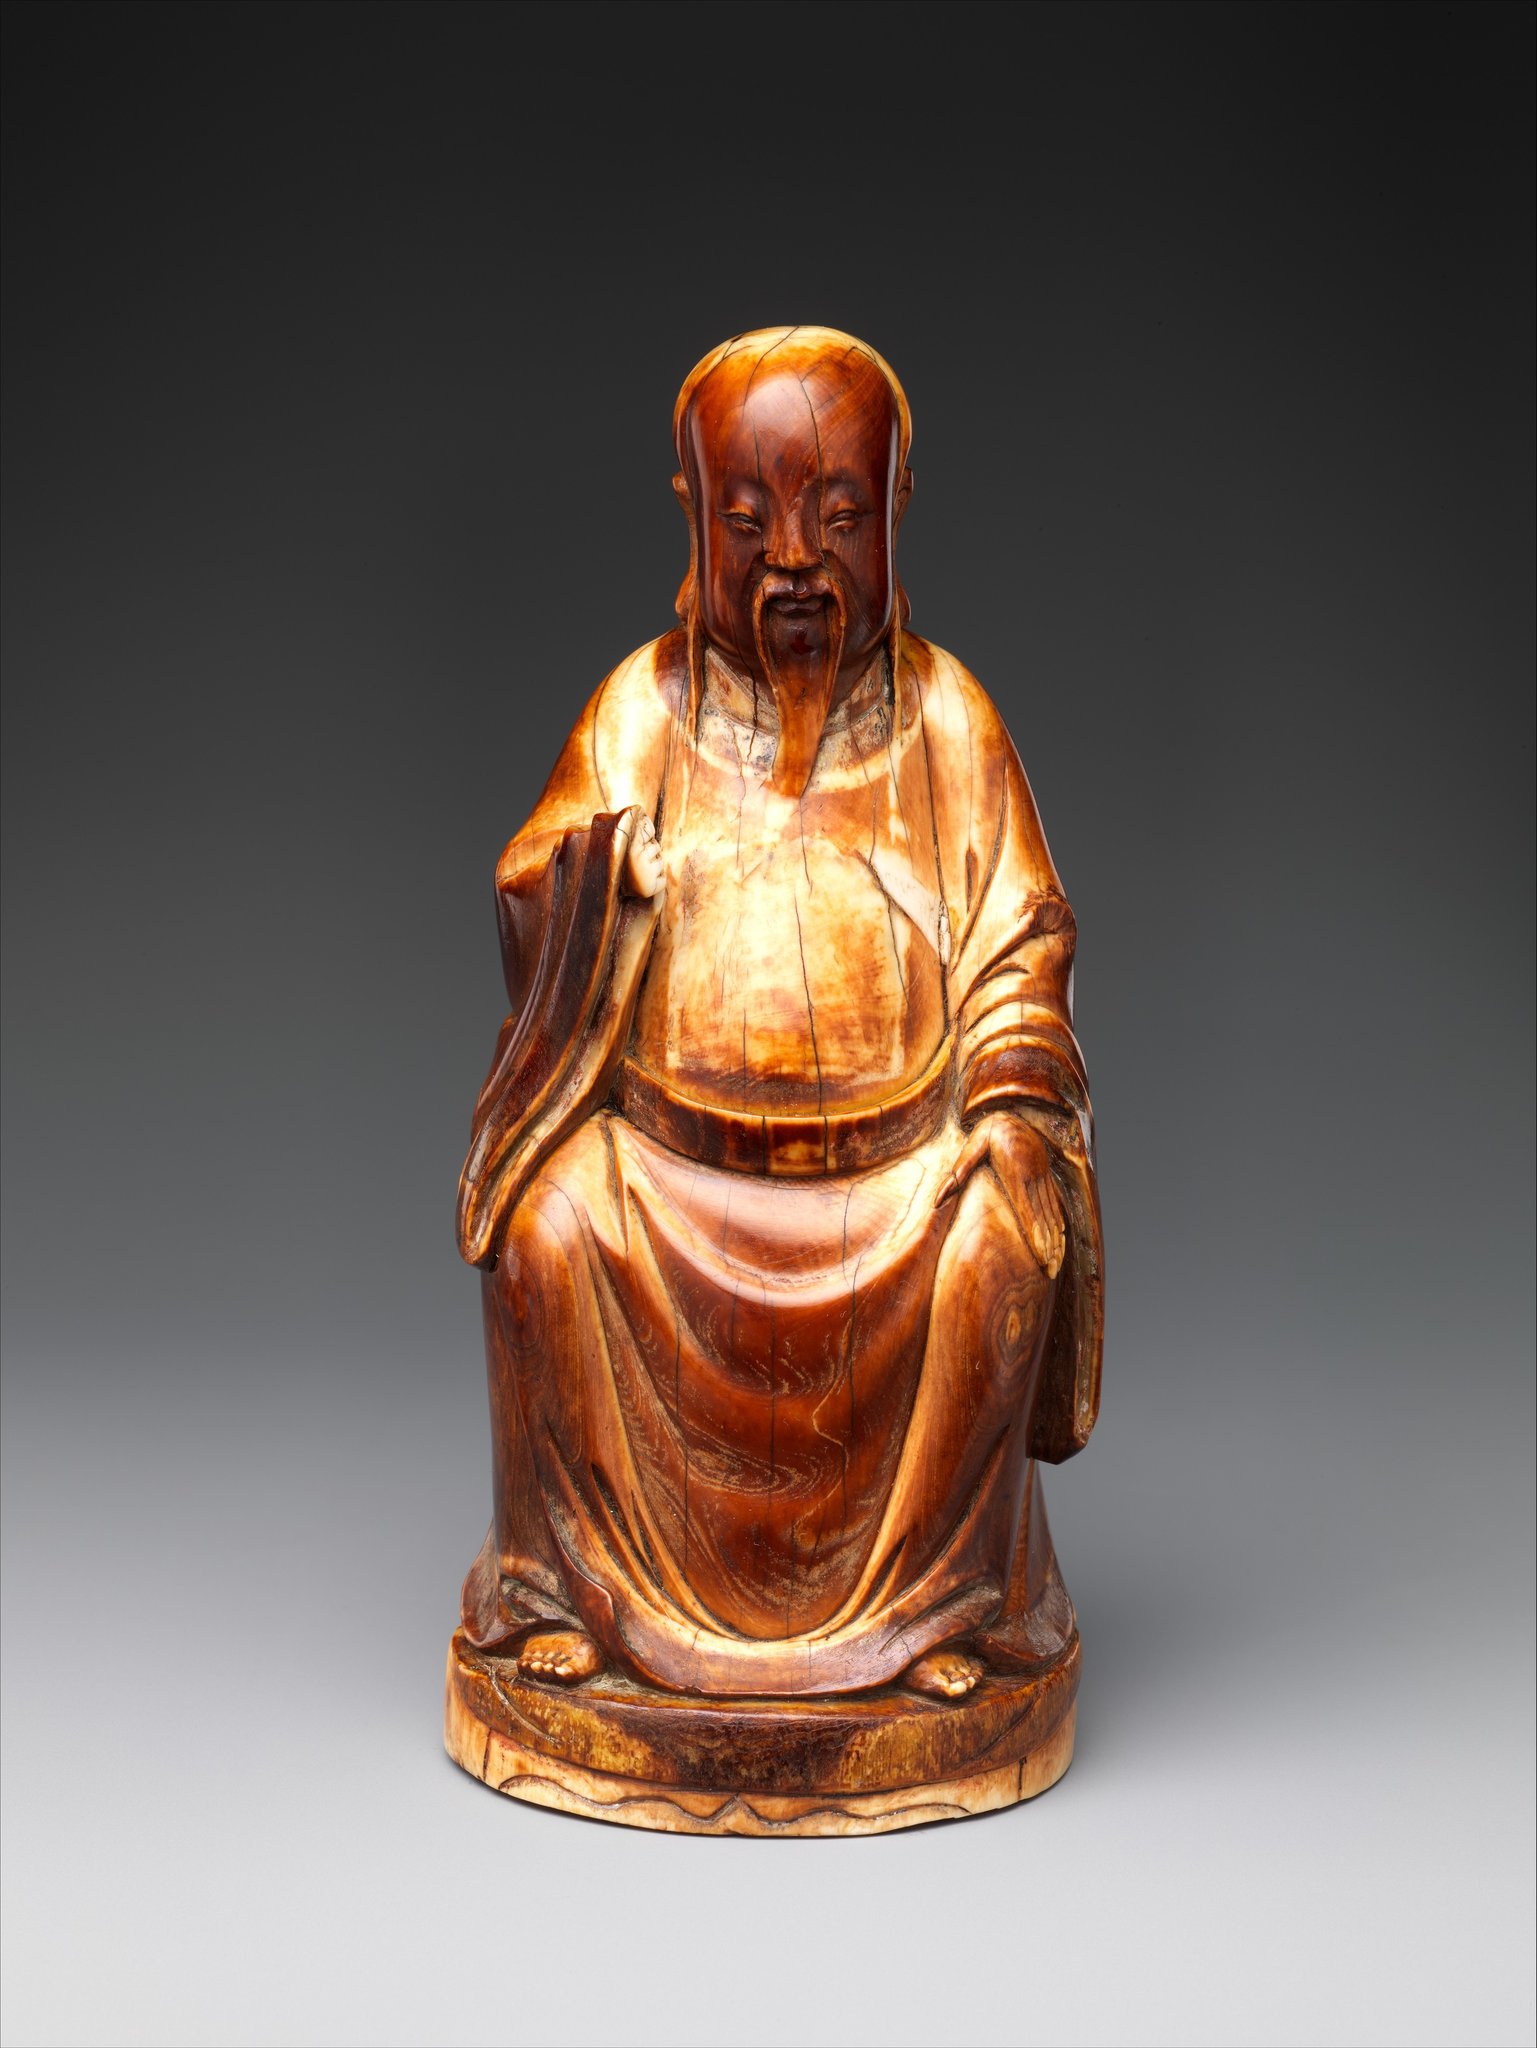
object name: figure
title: Wenchang, Stellar God of Literature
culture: chinese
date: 1501-1600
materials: ivory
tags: men